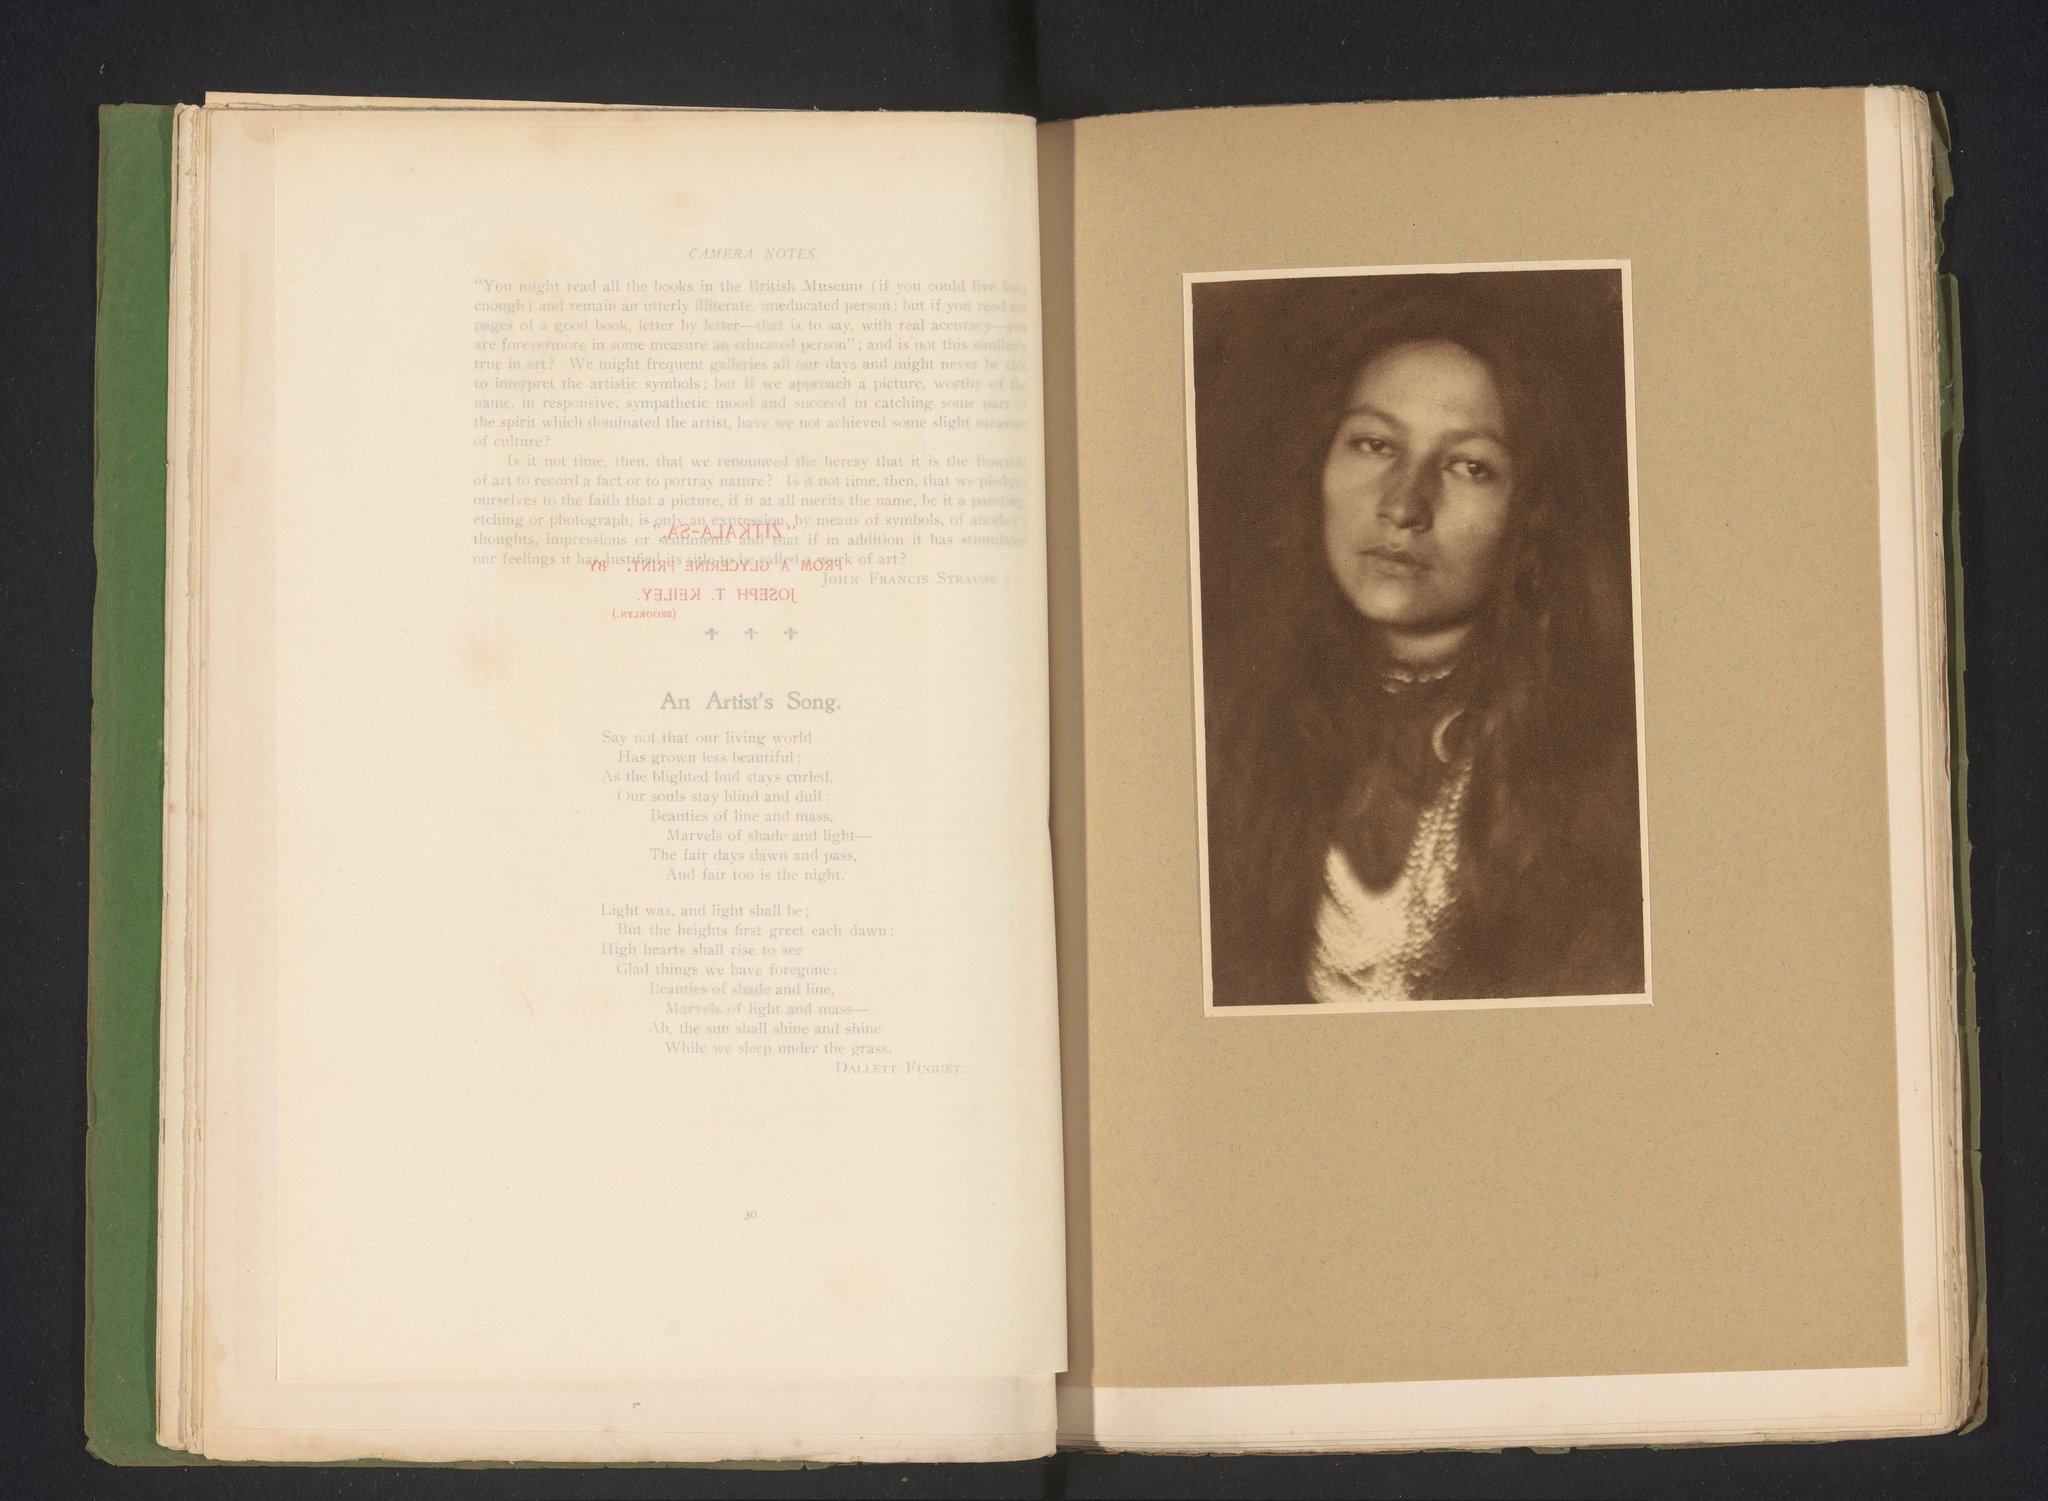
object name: page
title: Portret van een onbekende vrouw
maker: joseph turner keiley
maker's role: auteur, fotograaf, kunsthistoricus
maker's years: 1869-1914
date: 1896-1901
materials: paper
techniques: photoaquatint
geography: new york city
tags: historical persons not known by name - bb - woman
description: Prent tegenover pagina 30, achter semi-transparante omslag.